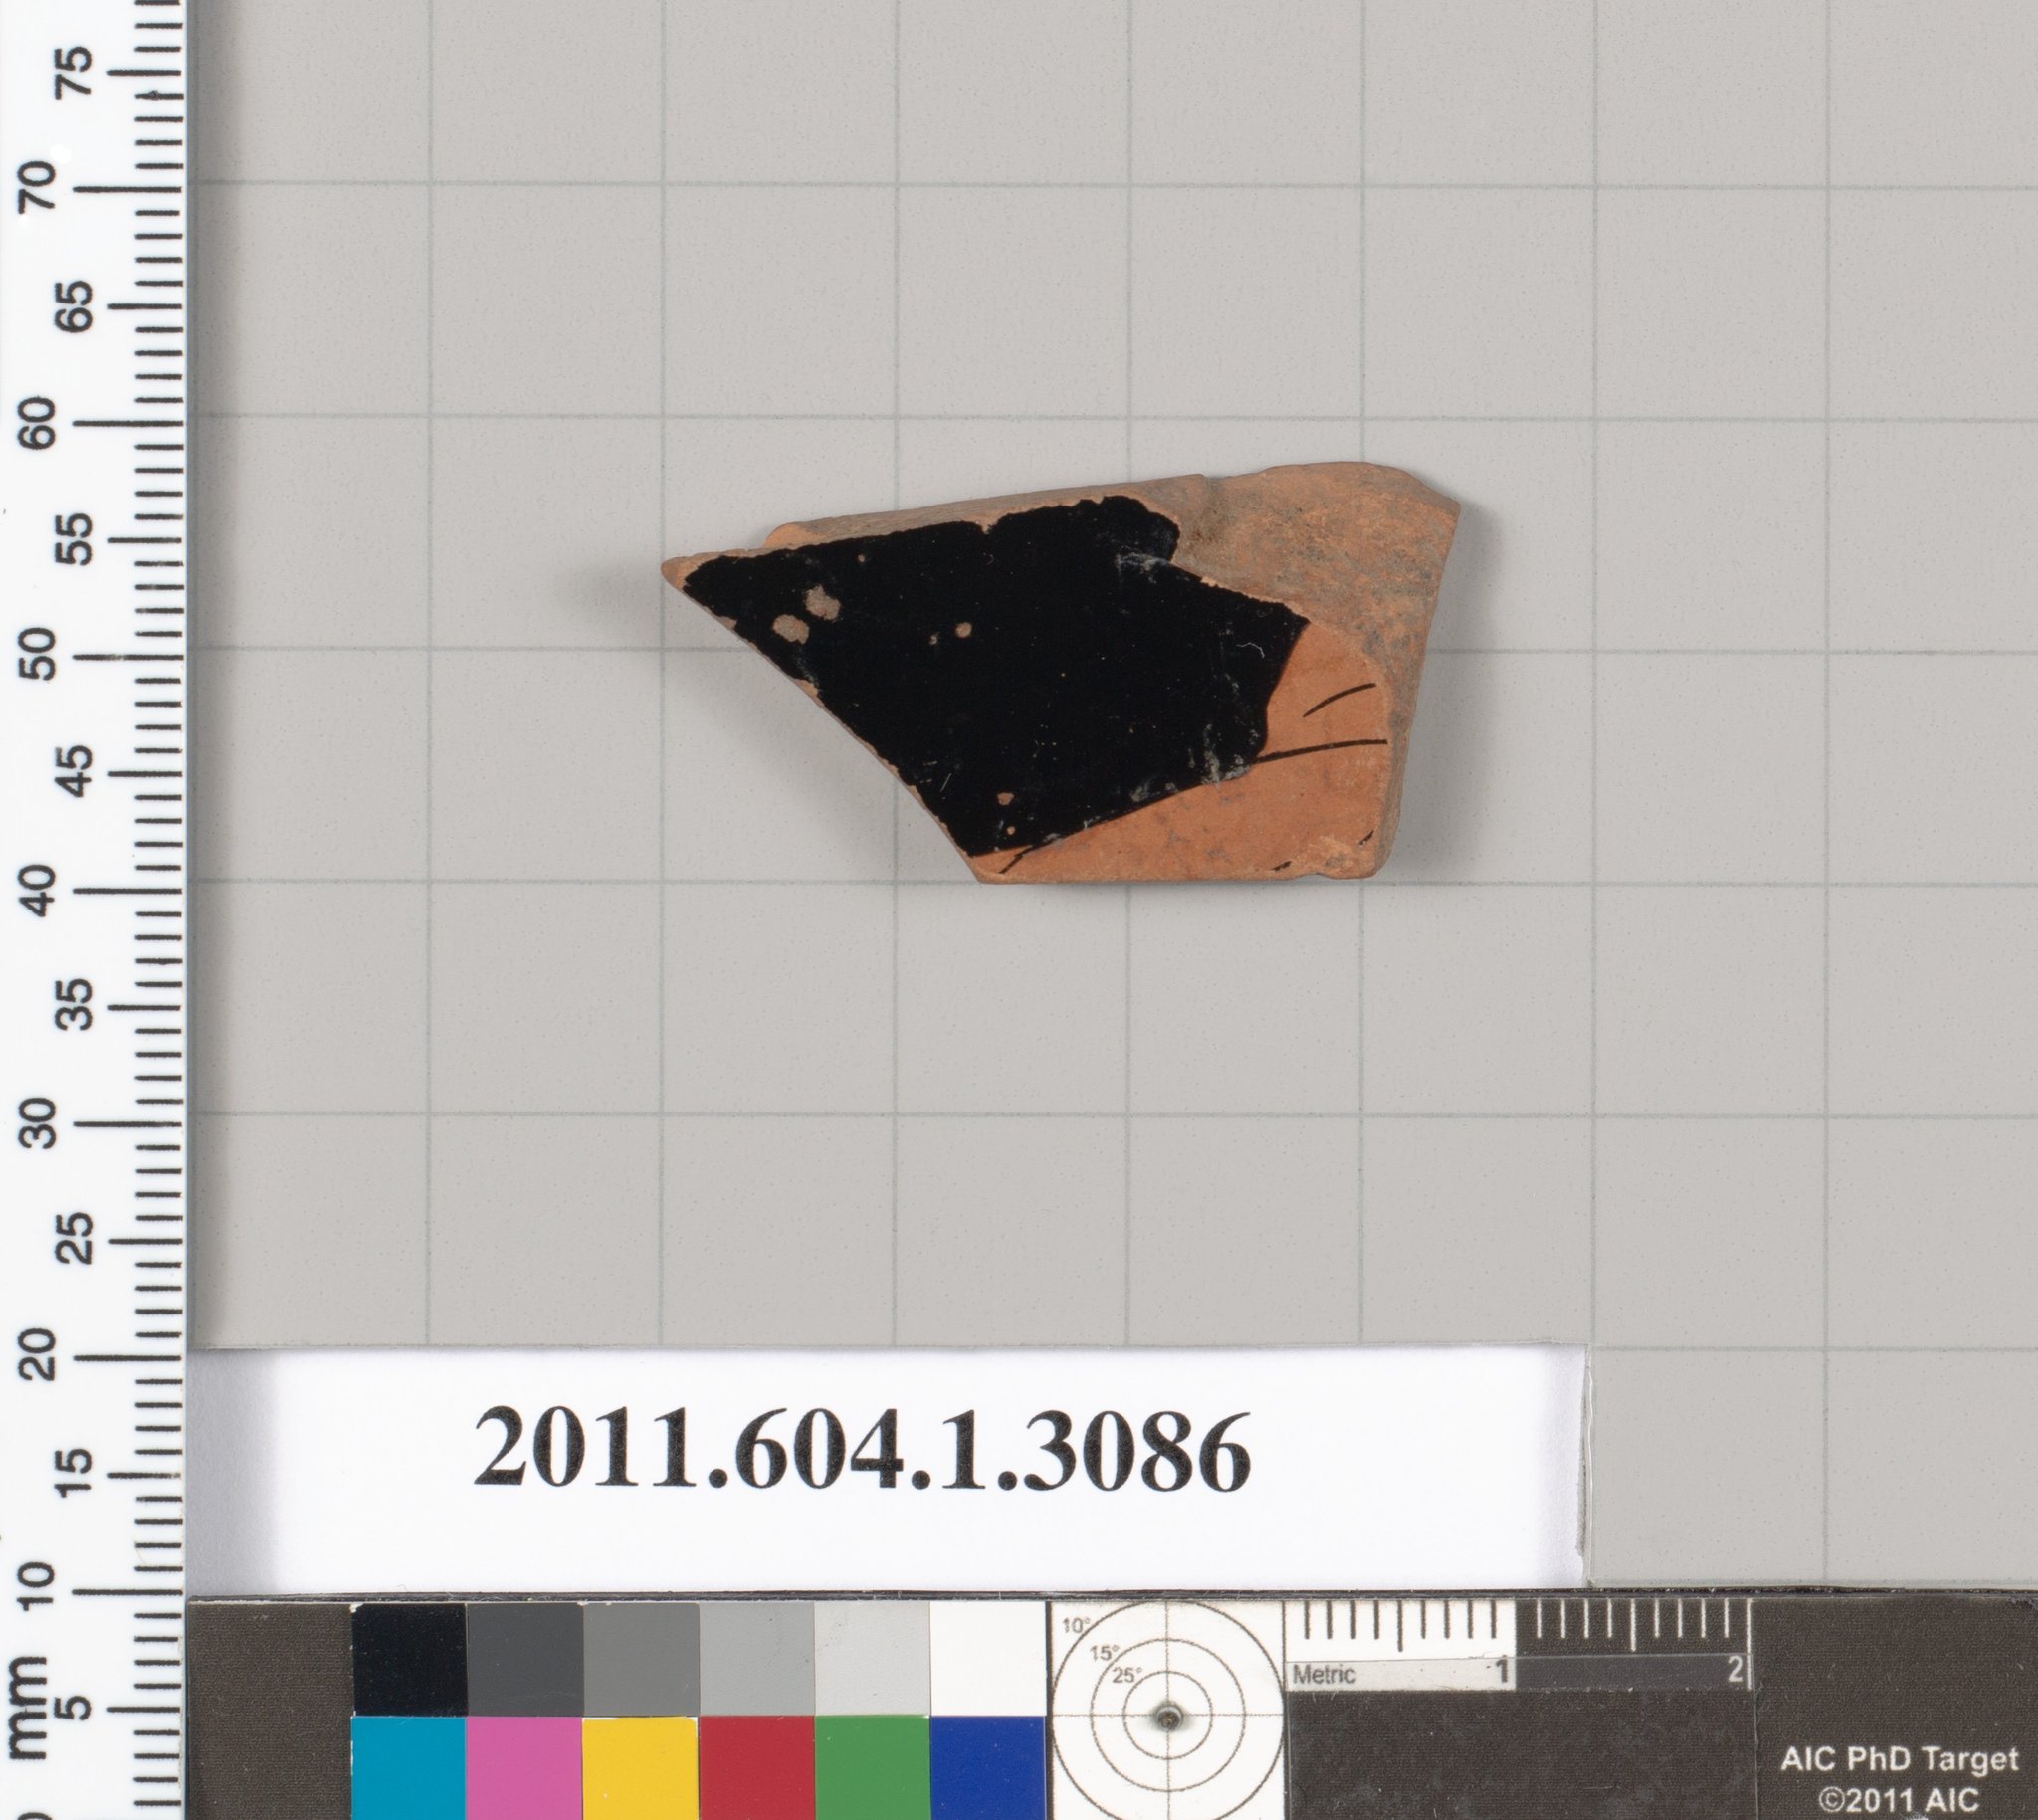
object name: kylix fragment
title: Terracotta fragment of a kylix (drinking cup)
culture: greek, attic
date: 500-451 BCE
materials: terracotta